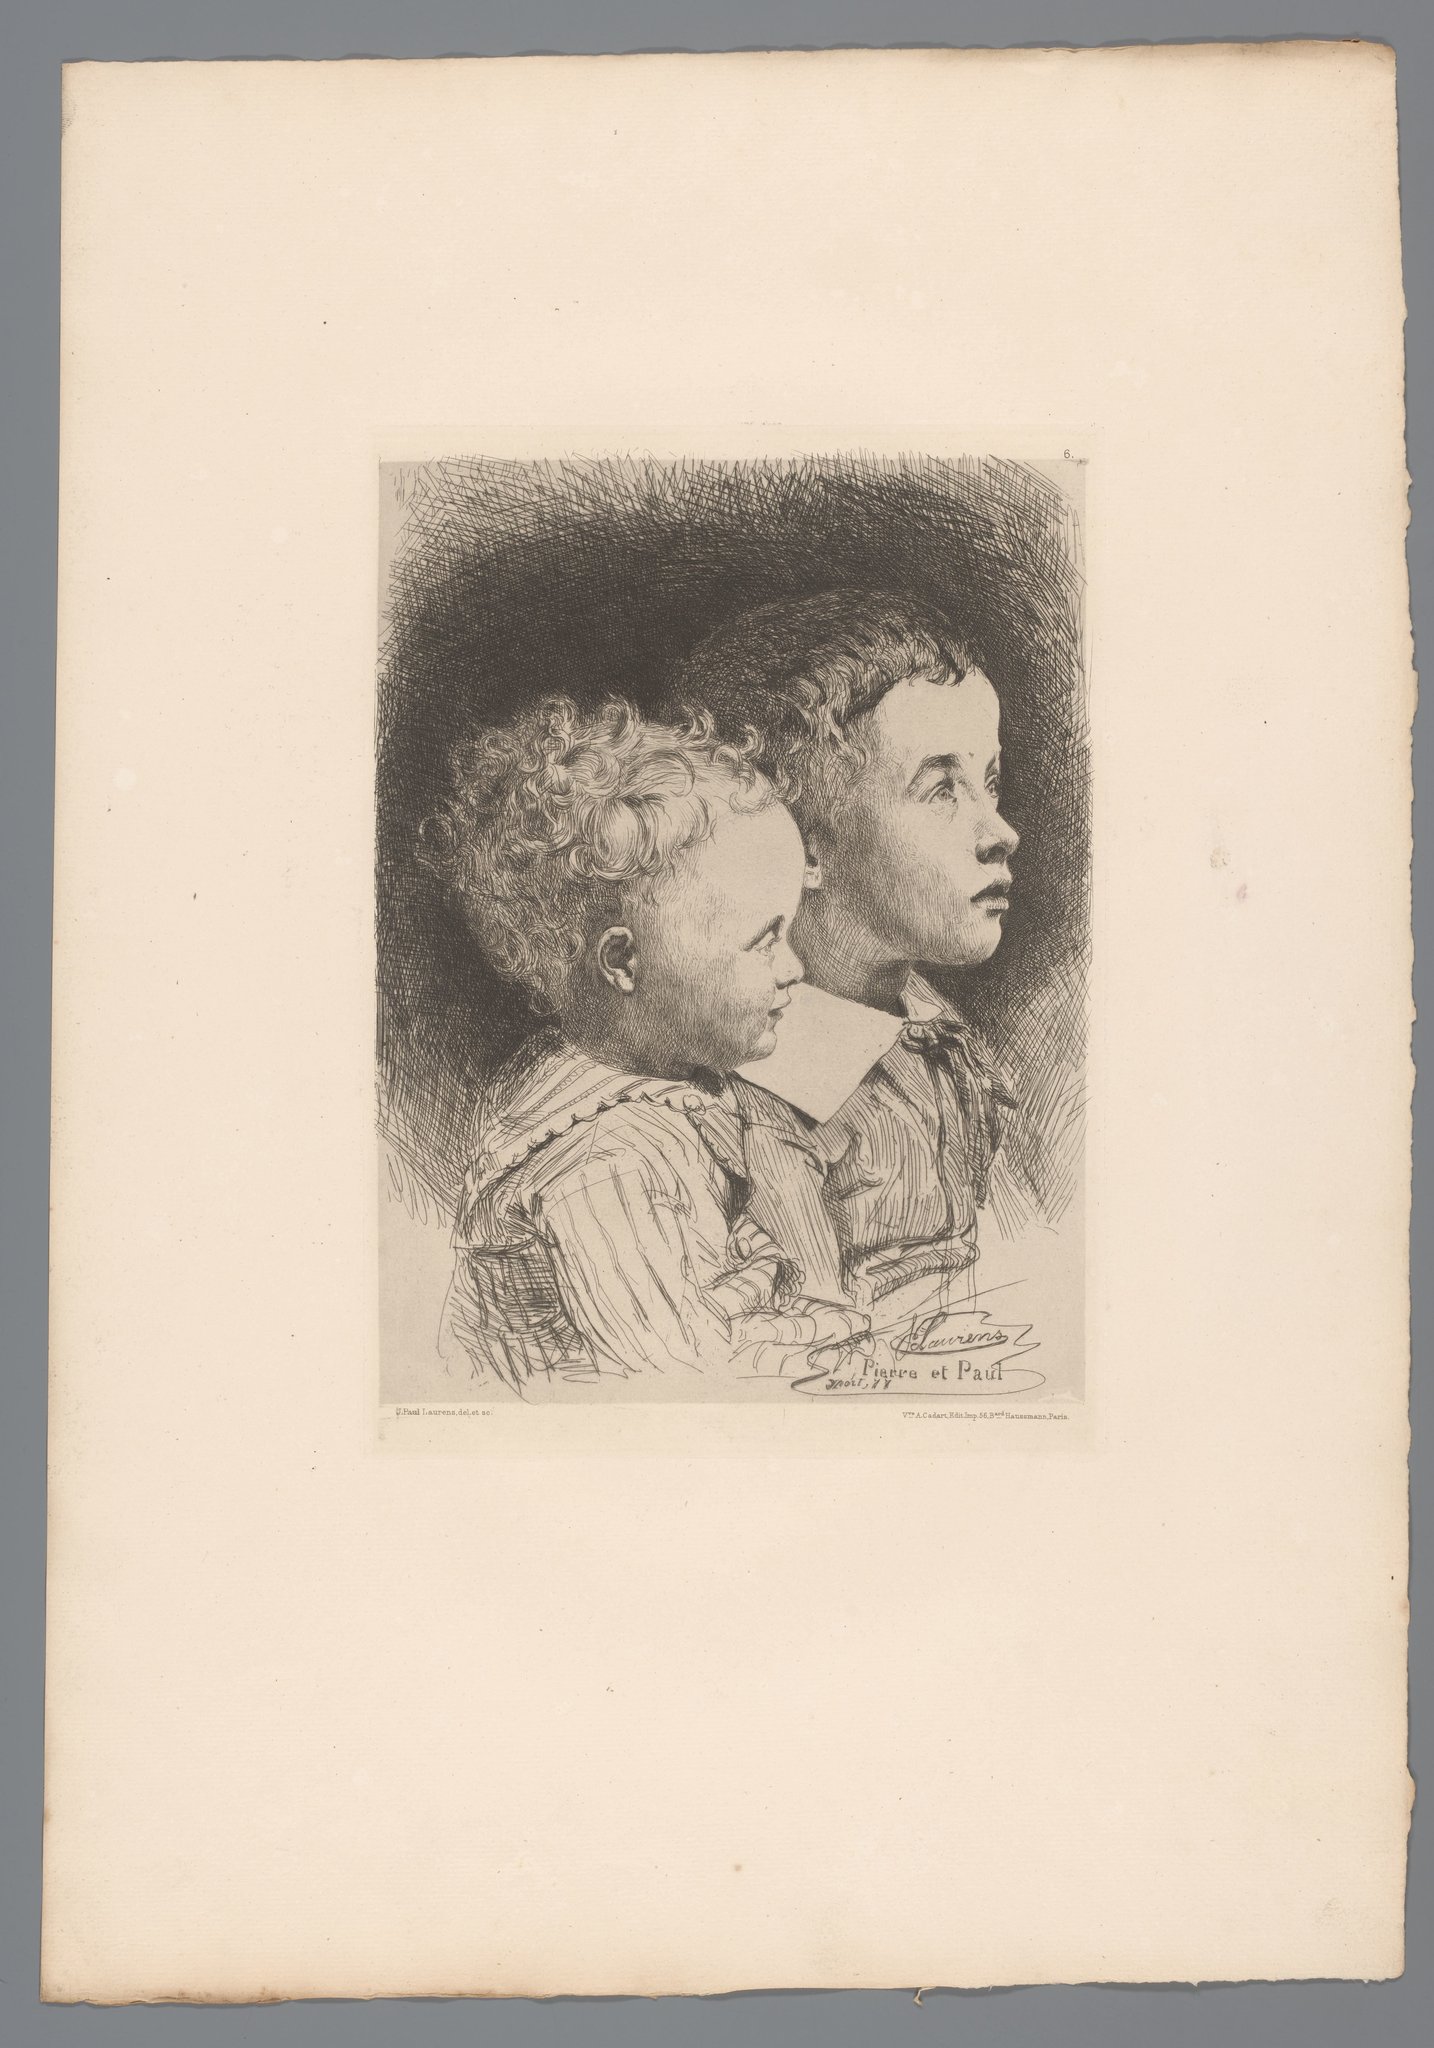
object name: print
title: L'eau-forte en 1878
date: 1878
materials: paper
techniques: drypoint, etching, intaglio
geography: paris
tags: paris, painter, jean pierre laurens, boy (child between toddler and youth), historical persons, toddler (male), brothers (second degree family relationships)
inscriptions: collector's mark: ‘AFE v S’, collector's mark: Lugt 2760, collector's mark: Lugt 2228, watermark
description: Portret van twee jongens, de zonen van de kunstenaar.